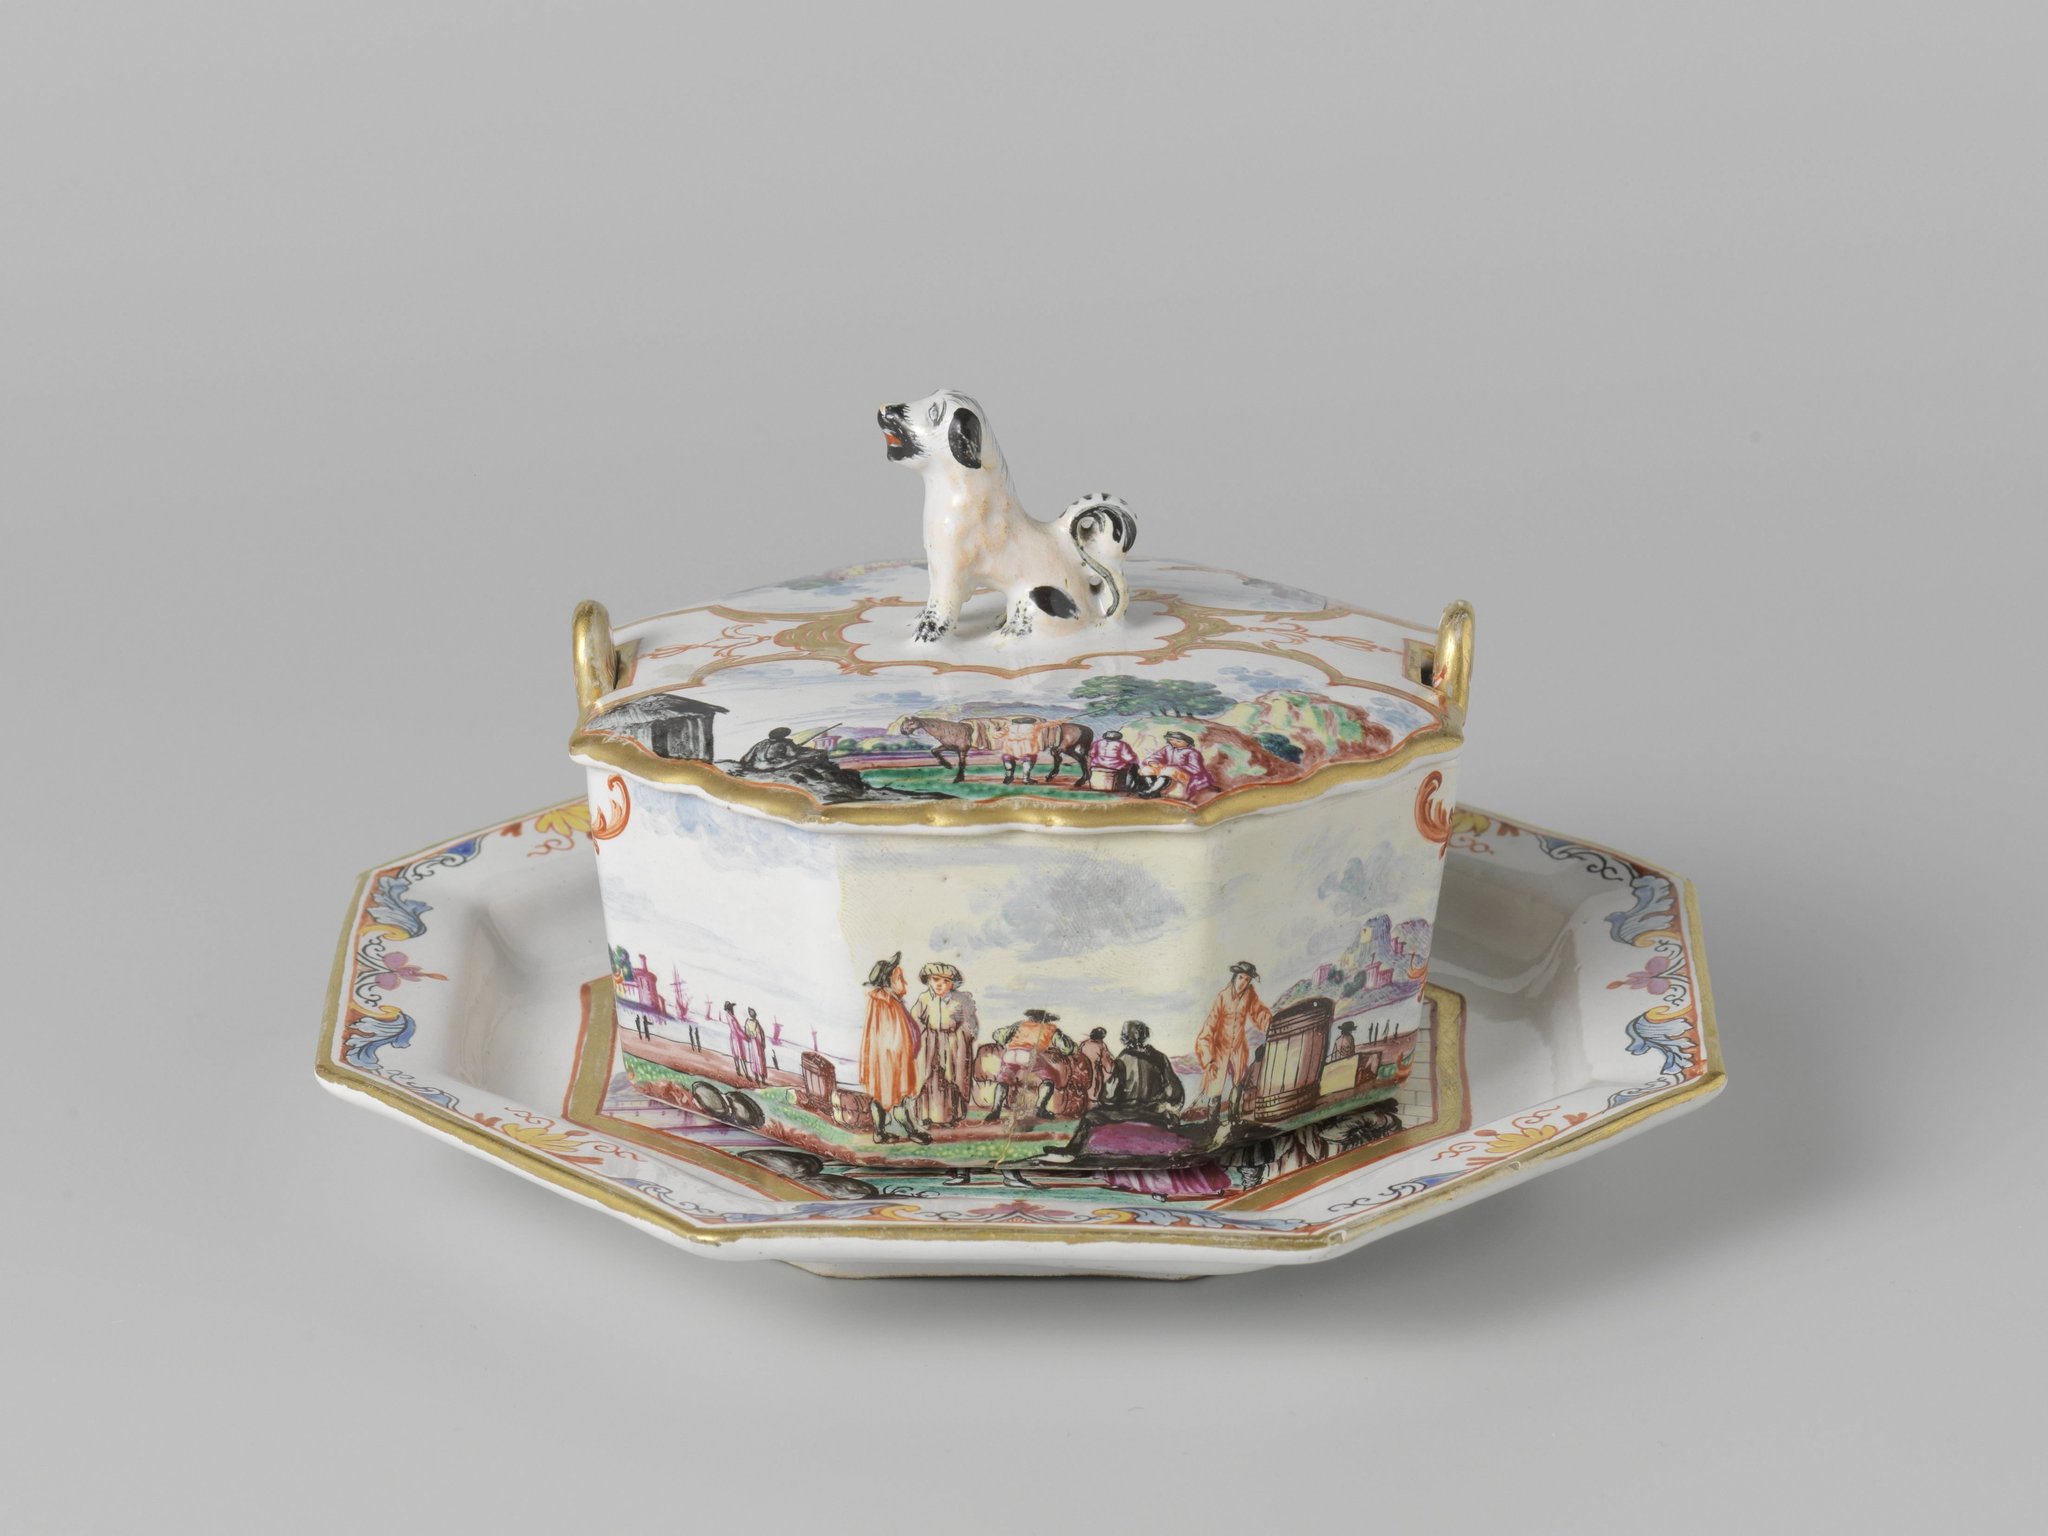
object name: butter dish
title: Butter dish and stand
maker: Anonymous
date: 1740-1765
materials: earthenware, glaze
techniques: kiln, painted, polychromy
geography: delft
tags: landscapes in the temperate zone, dog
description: Botervloot (A) met deksel (C) veelkleurig beschilderd. De botervloot staat op een onderschotel (B). De knop van het deksel heeft de vorm van een hond.